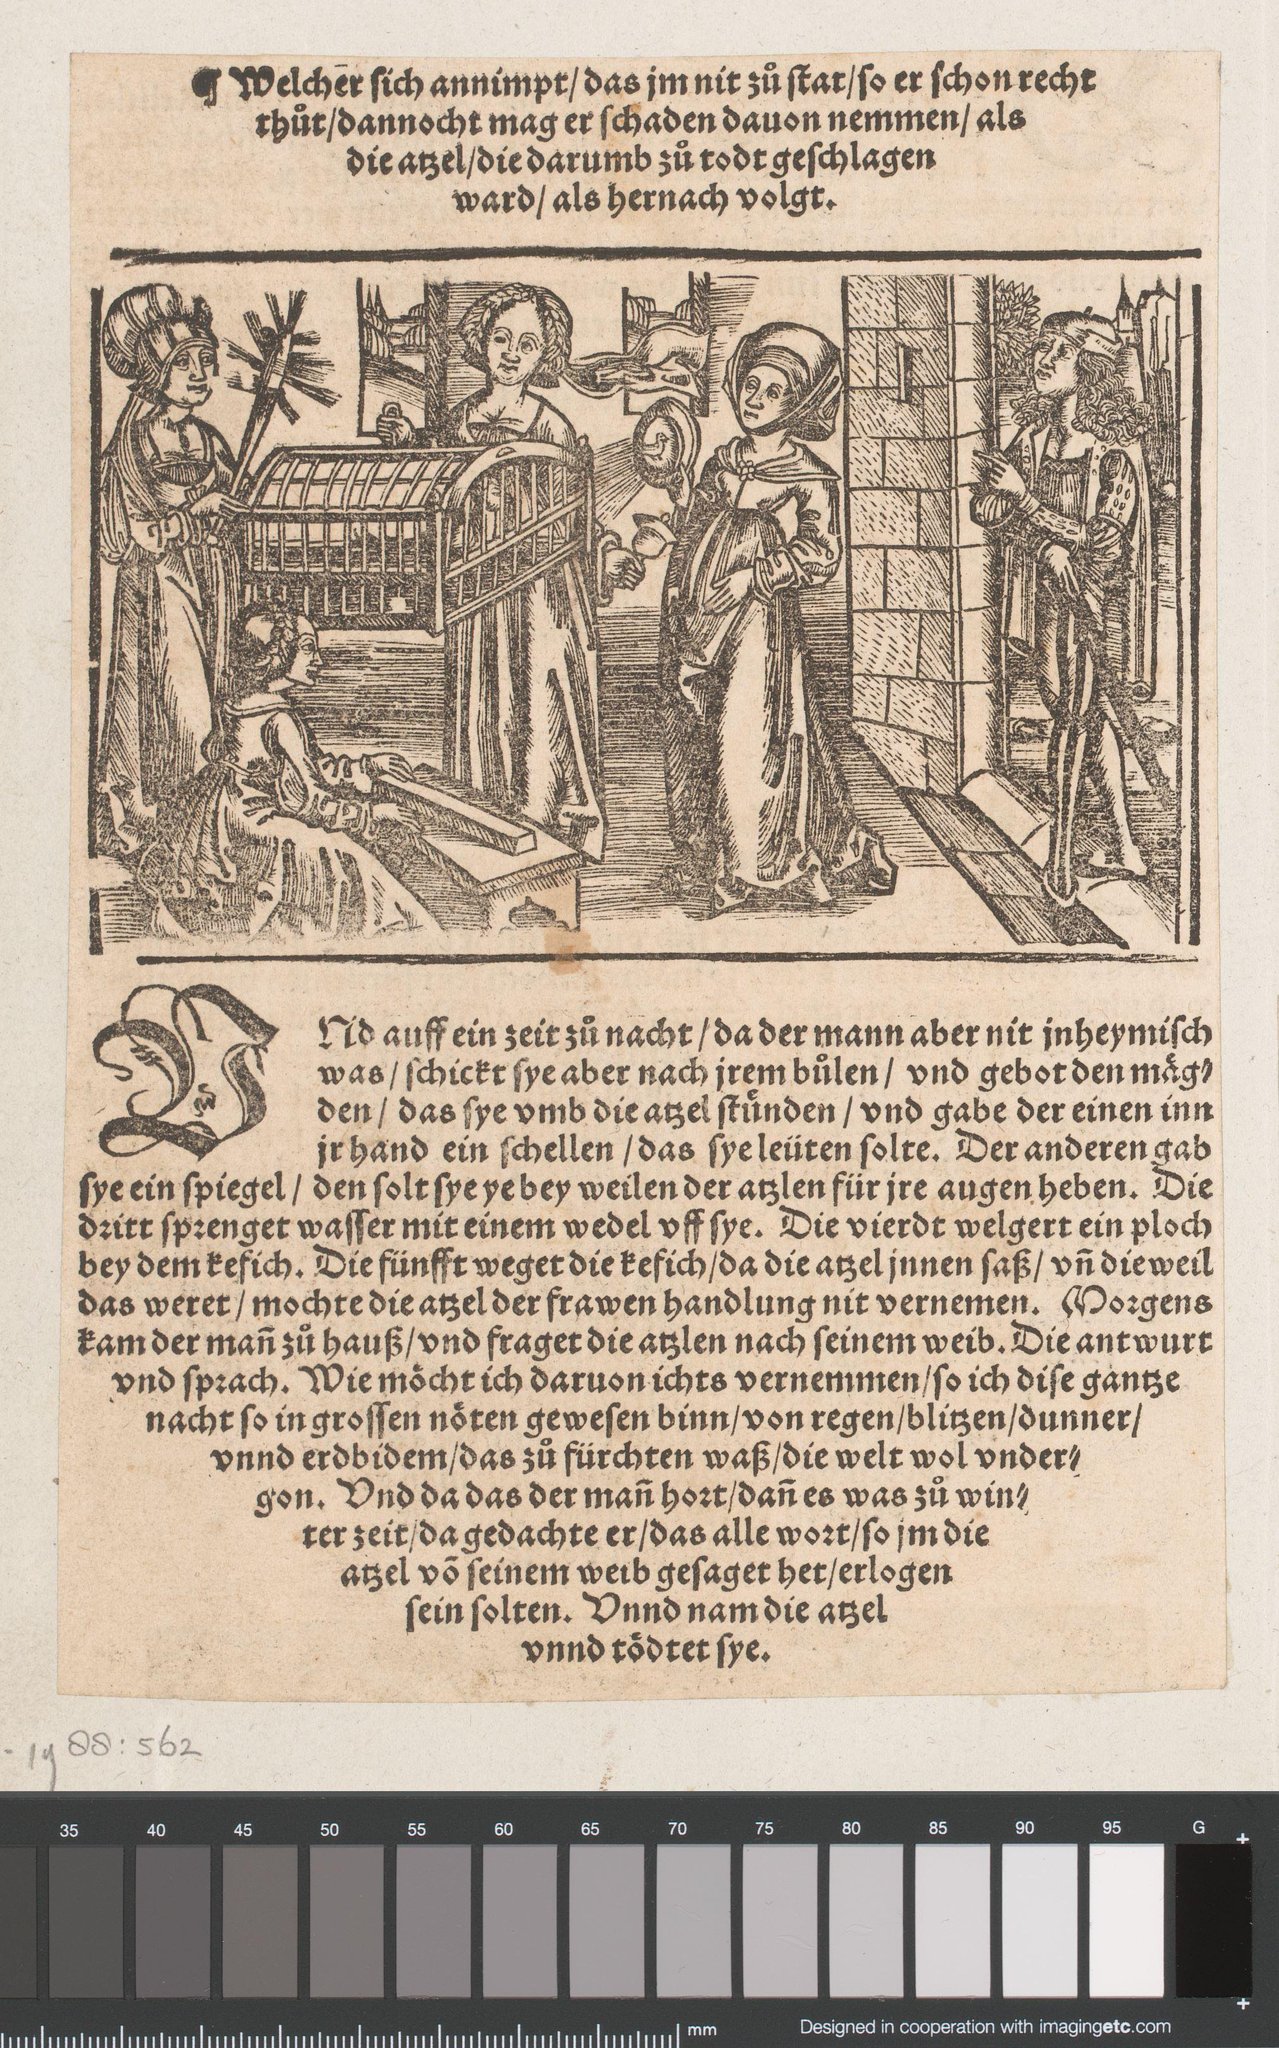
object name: print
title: Vier vrouwen met verschillende voorwerpen in een interieur, een man staat in de deuropening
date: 1539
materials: paper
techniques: woodcut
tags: christian religion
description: Illustratie uit: Bidpai. Das büch der Weissheyt der Alten weisen. Straatsburg: Jacob Fröhlich, 1539.